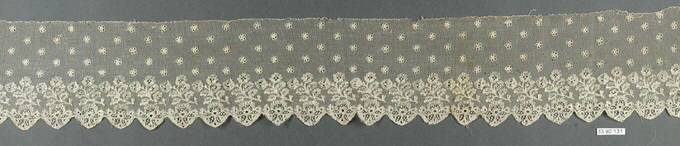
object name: edging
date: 1767-1800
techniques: lace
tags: flowers